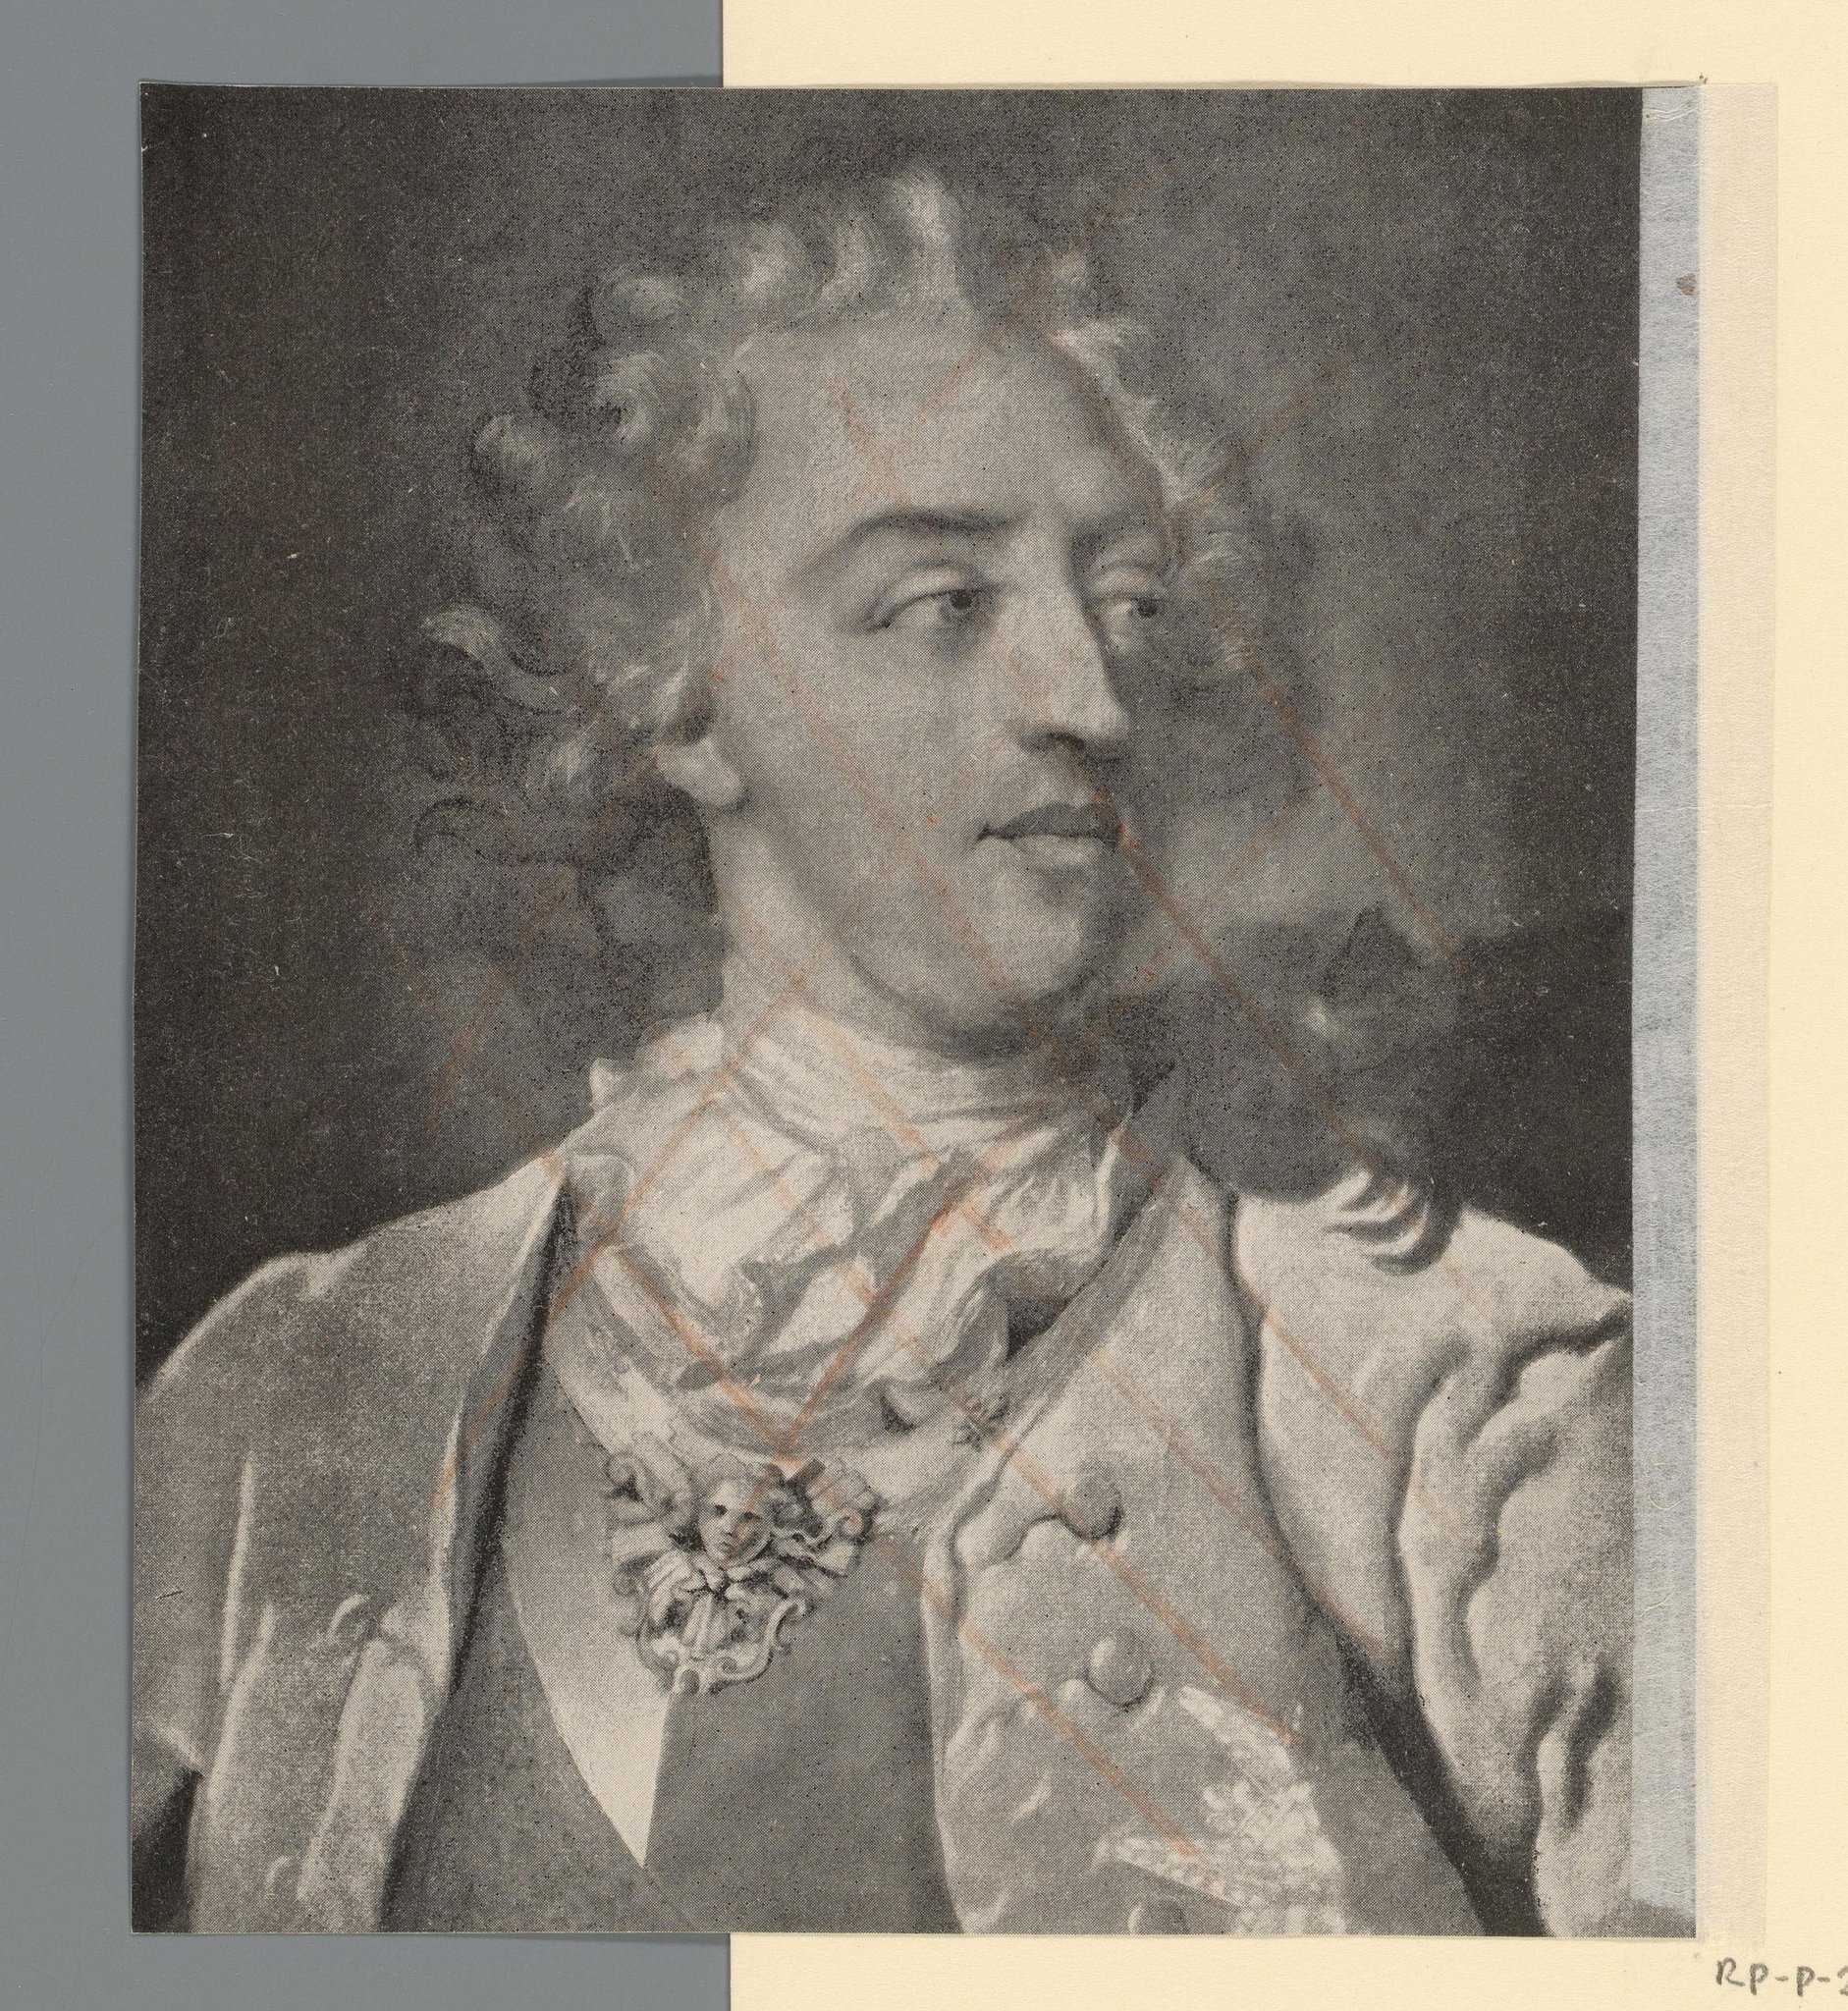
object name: photomechanical print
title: Portret van Lodewijk XV, koning van Frankrijk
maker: Anonymous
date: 1875-1899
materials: paper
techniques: autotype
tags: louis xv of france, historical persons, king